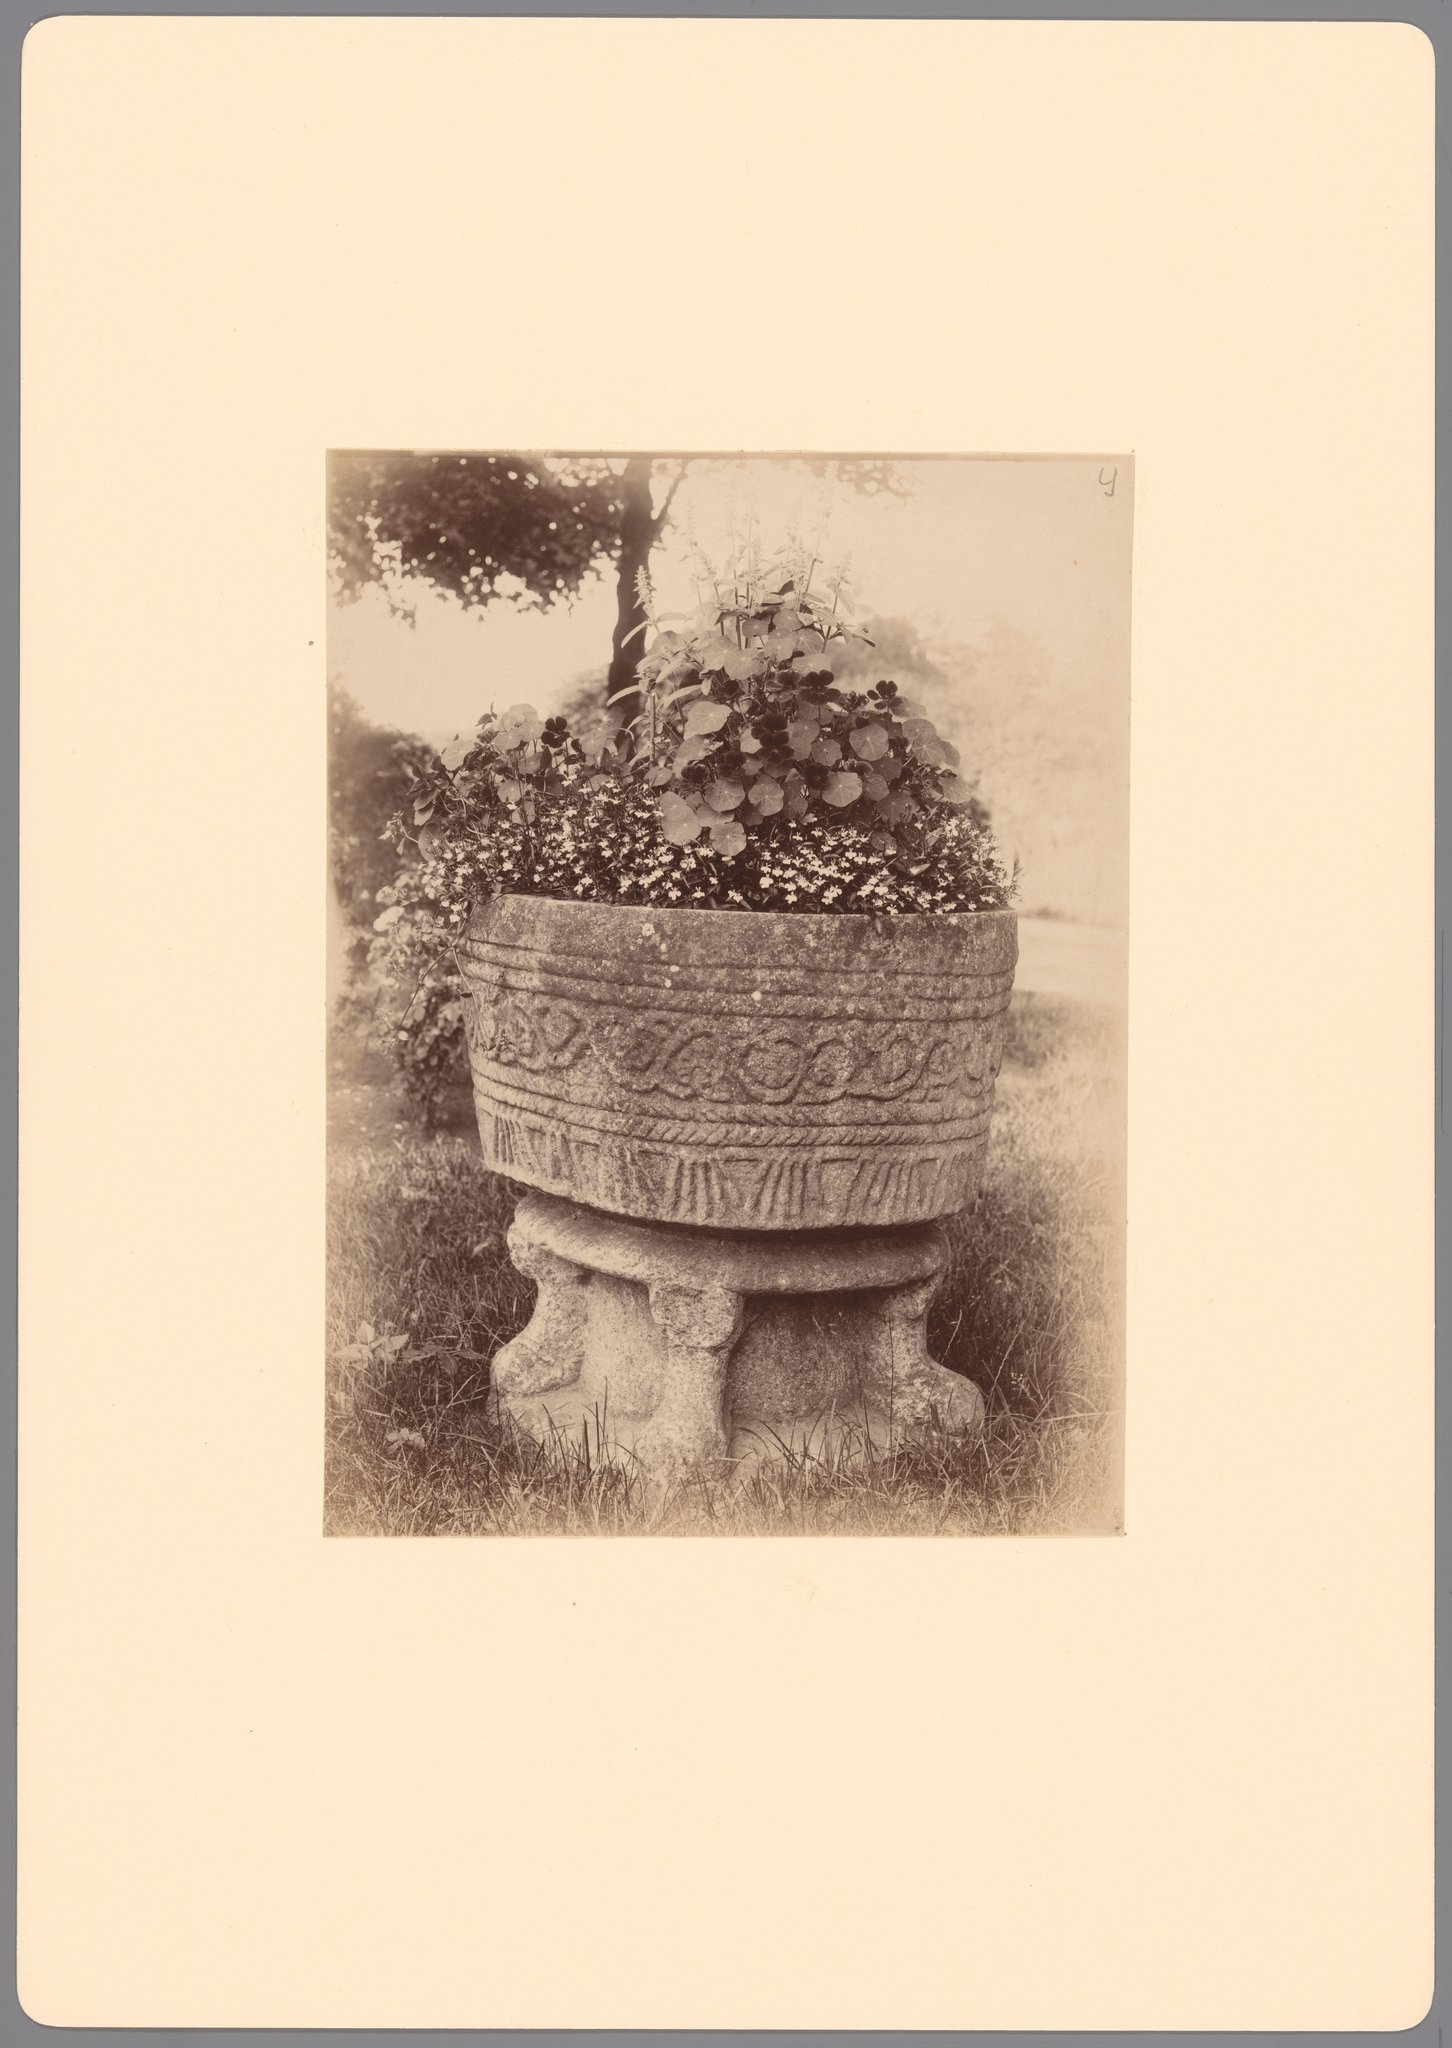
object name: photograph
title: Doopvont met bloemen in het plantsoen te Hattem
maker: anoniem (monumentenzorg)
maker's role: fotograaf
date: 1890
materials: cardboard, photographic support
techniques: albumen print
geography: hattem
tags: flowers, baptismal font - qq - baptism in the open air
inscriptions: annotation: ‘y’, annotation: ‘Doopvont staande in het plantsoen juli 1890/ Hattum’